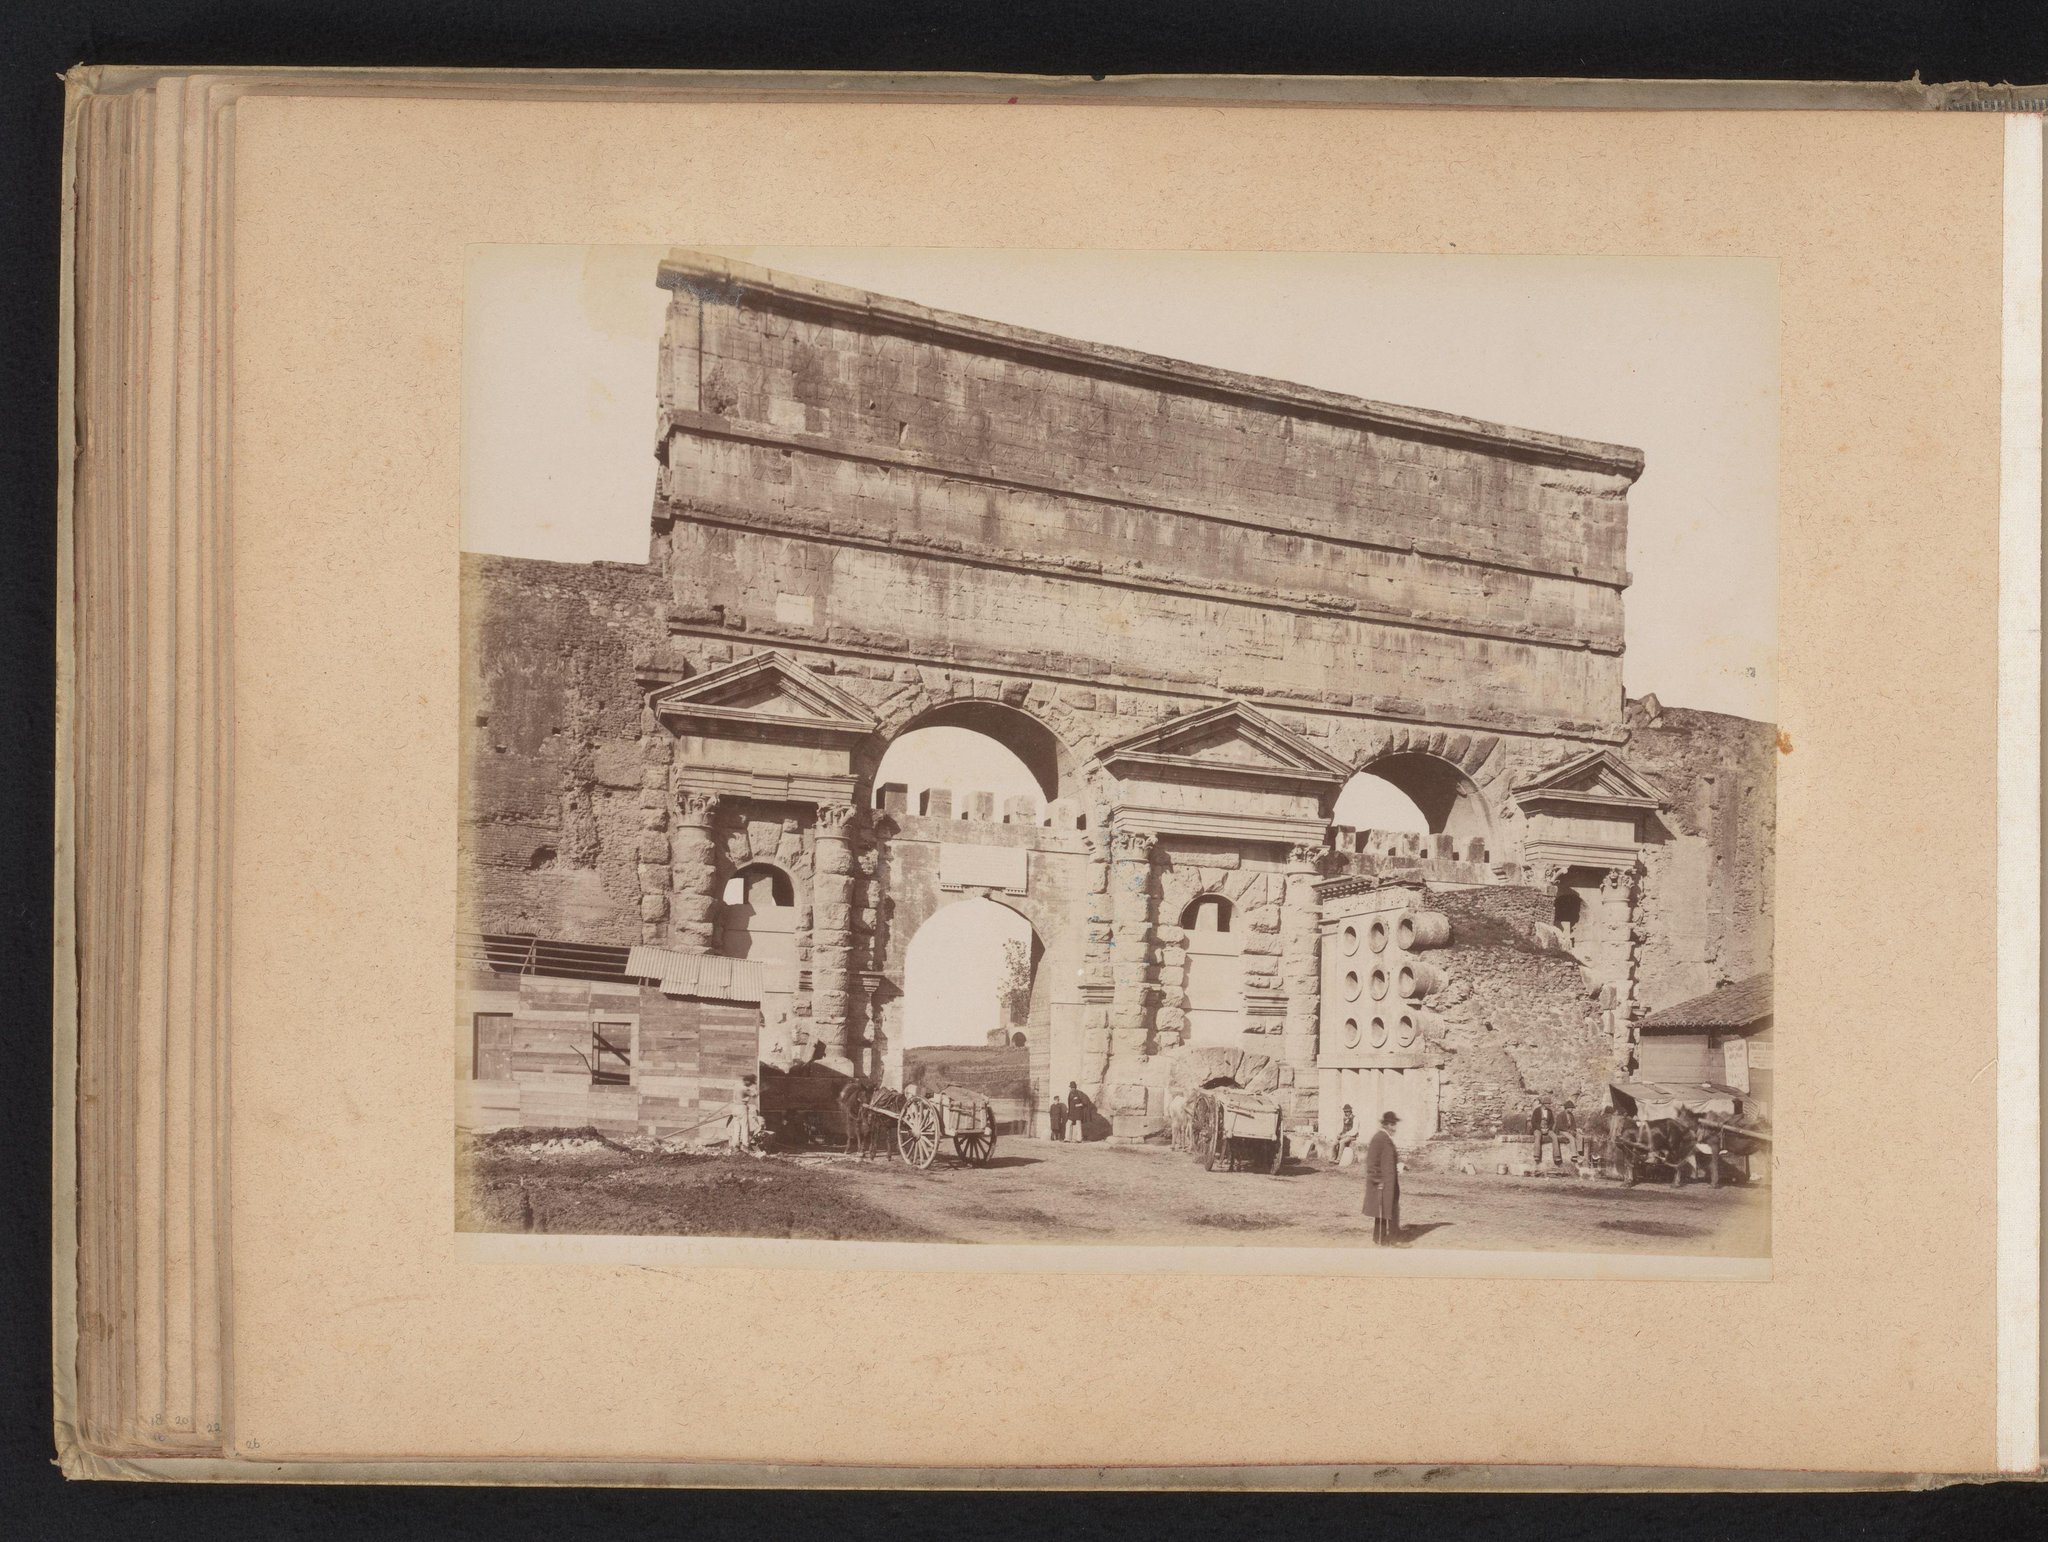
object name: album leaf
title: Gezicht op de Porta Maggiore in Rome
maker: Anonymous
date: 1870-1895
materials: cardboard, photographic support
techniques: albumen print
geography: rome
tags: city-gate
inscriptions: inscription: ‘448 PORTA MAGGIORE’